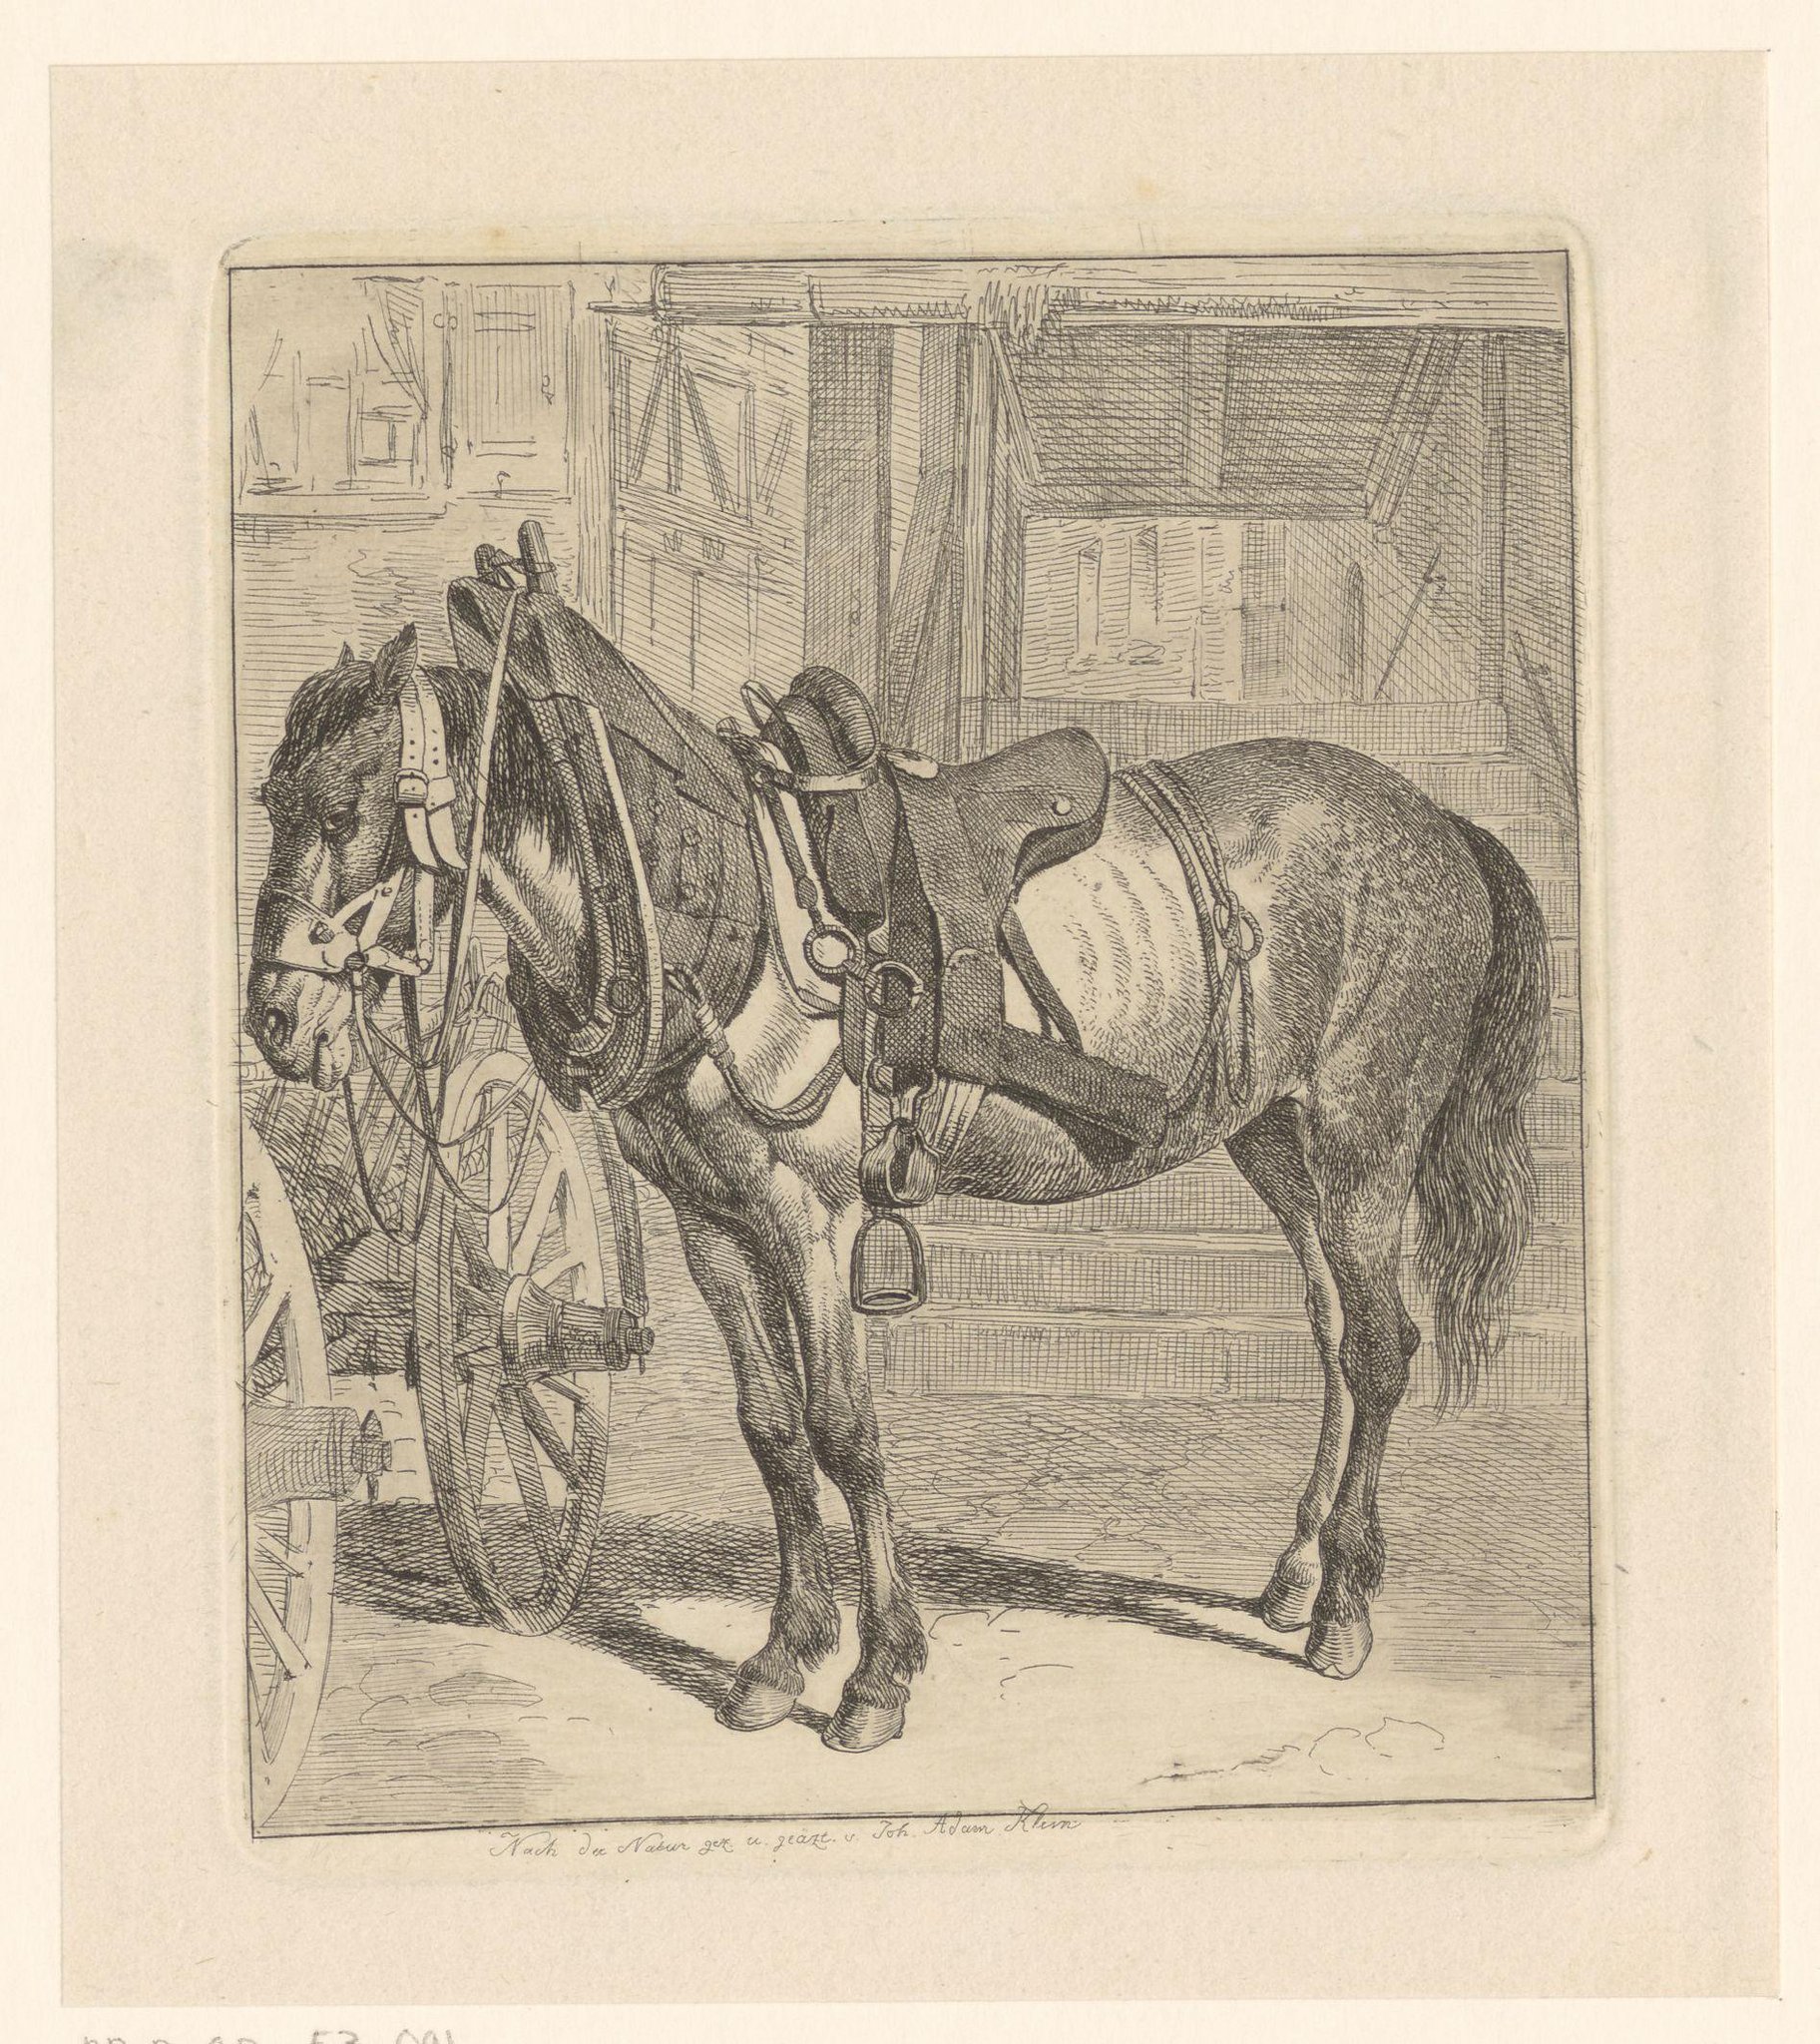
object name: print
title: Paard met paardentuig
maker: johann adam klein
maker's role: draughtsman, print maker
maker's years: 1792-1875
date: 1802-1875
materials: paper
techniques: etching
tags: saddling and bridling, horse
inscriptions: collector's mark: Lugt 2228